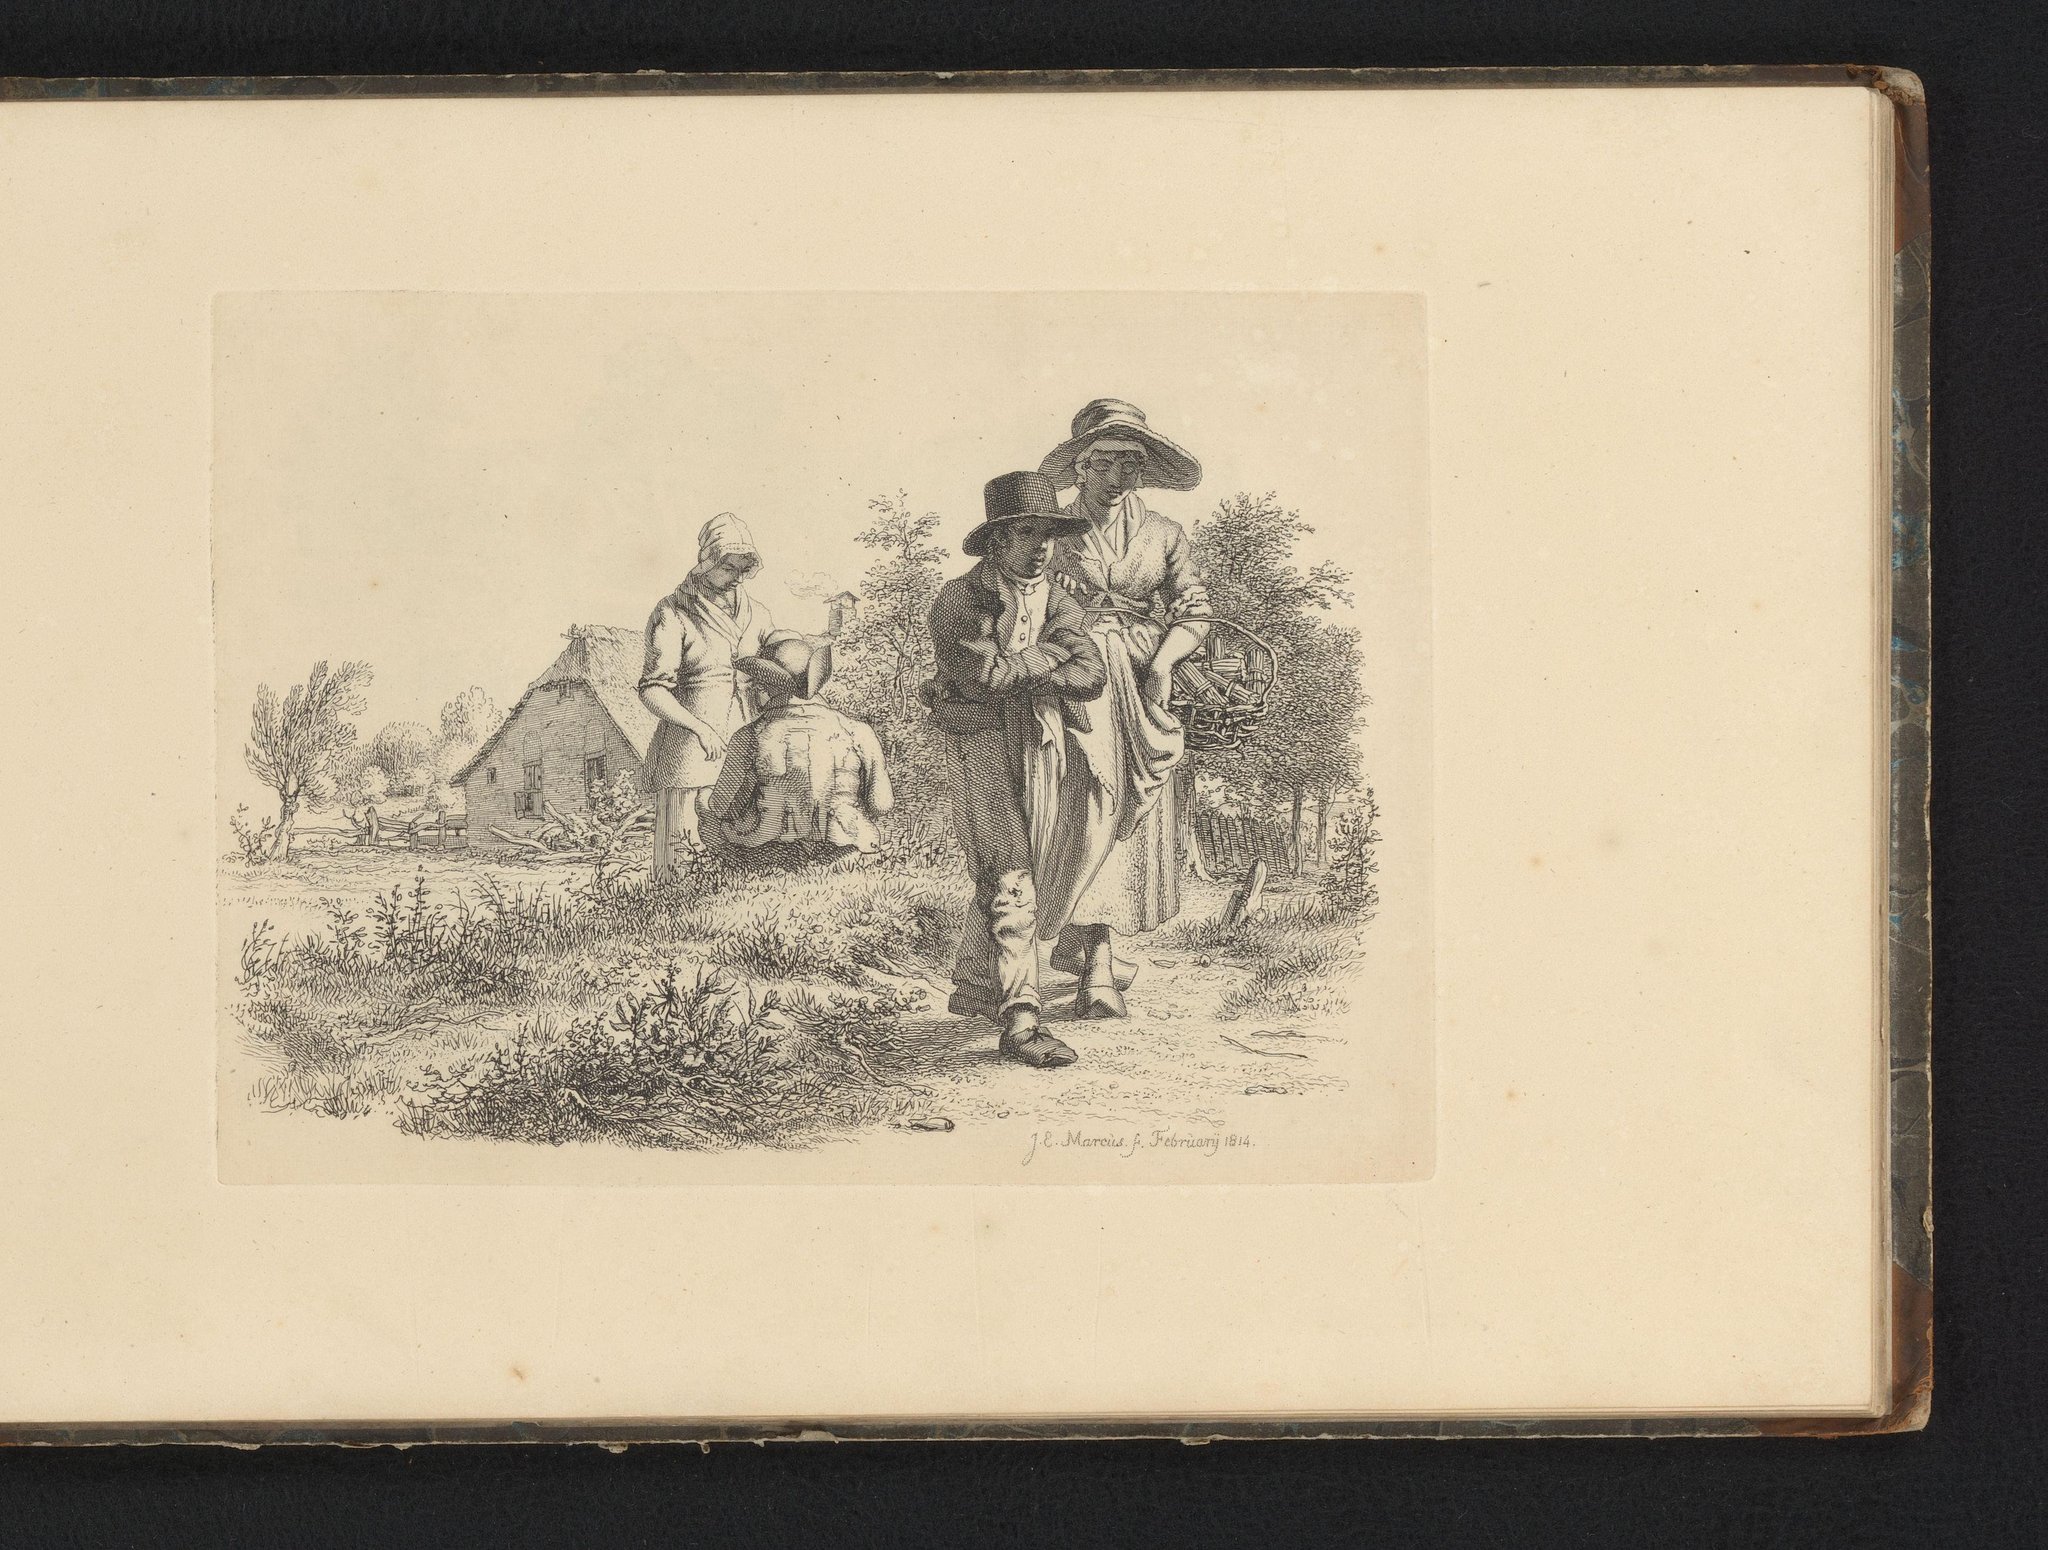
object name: album leaf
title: Blinde vrouw en converserende figuren bij een boerderij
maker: jacob ernst marcus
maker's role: draughtsman, print maker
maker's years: 1774-1826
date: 1802-1814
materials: paper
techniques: etching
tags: sulphur match, blind, blindness, carrying something in basket, bag, rucksack, etc.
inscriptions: date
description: Een blinde vrouw met een mand met zwavelstokjes wordt geleid door een jongen. Achter hen een converserende staande vrouw en een zittende man die op de rug is gezien. Op de achtergrond een boerderij. Deze prent maakt deel uit van een album.